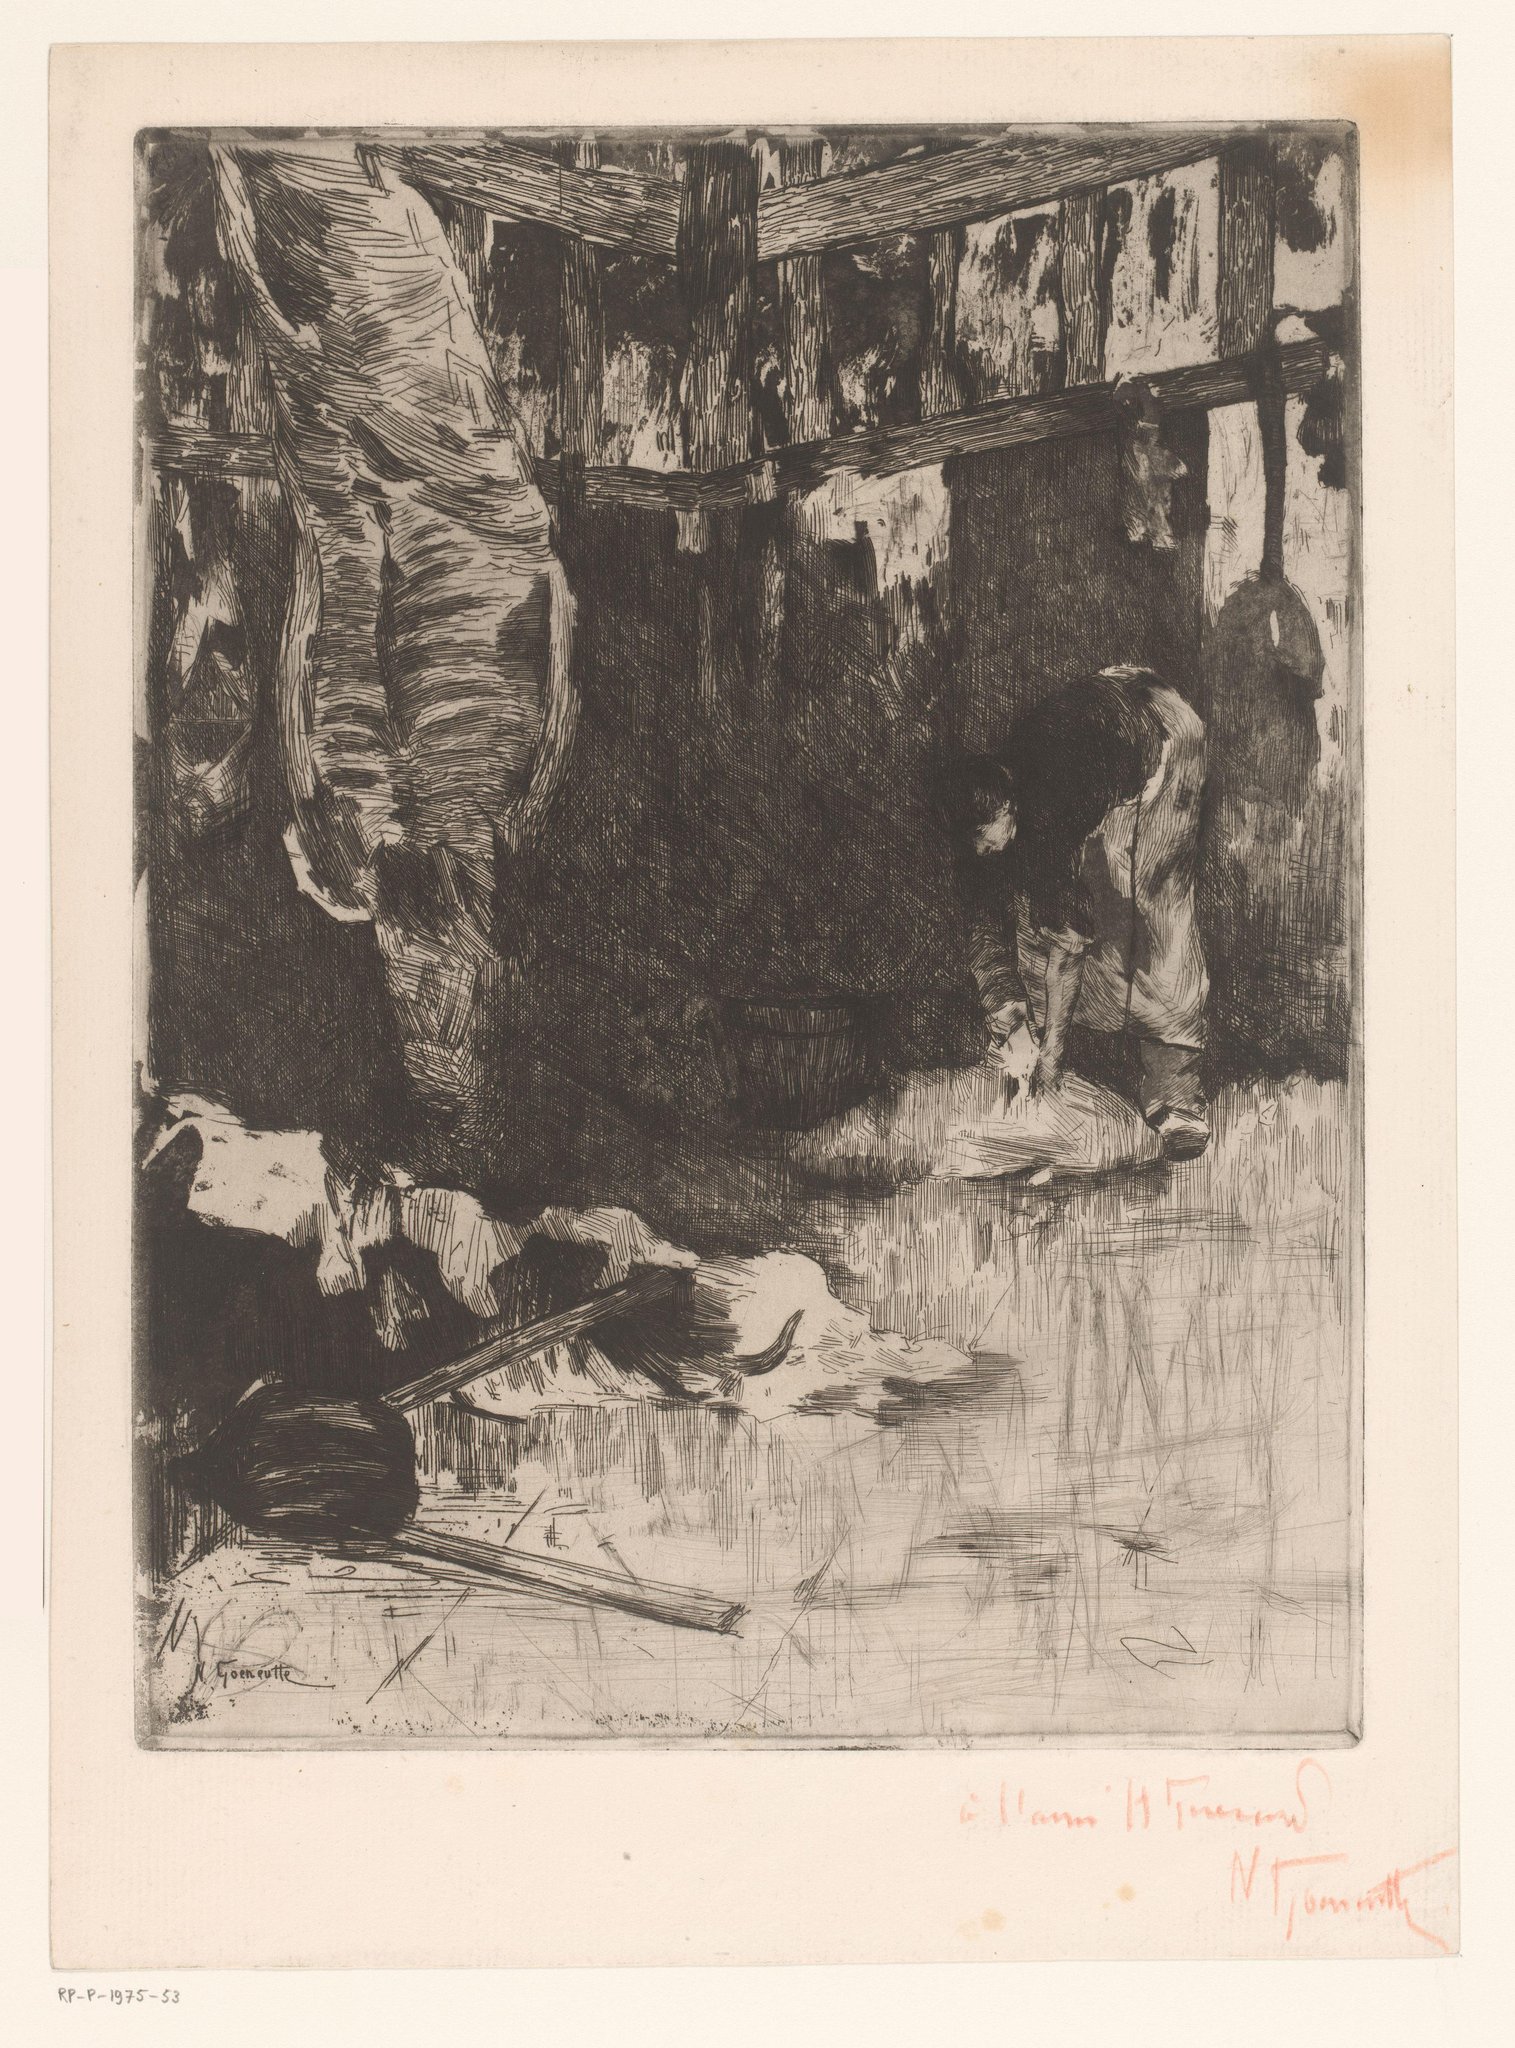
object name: print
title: Interieur van een slagerij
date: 1888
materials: paper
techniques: aquatint, drypoint, etching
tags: slaughtered ox or pig, butcher, slaughterman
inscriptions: collector's mark: Lugt 2760, collector's mark: Lugt 2228